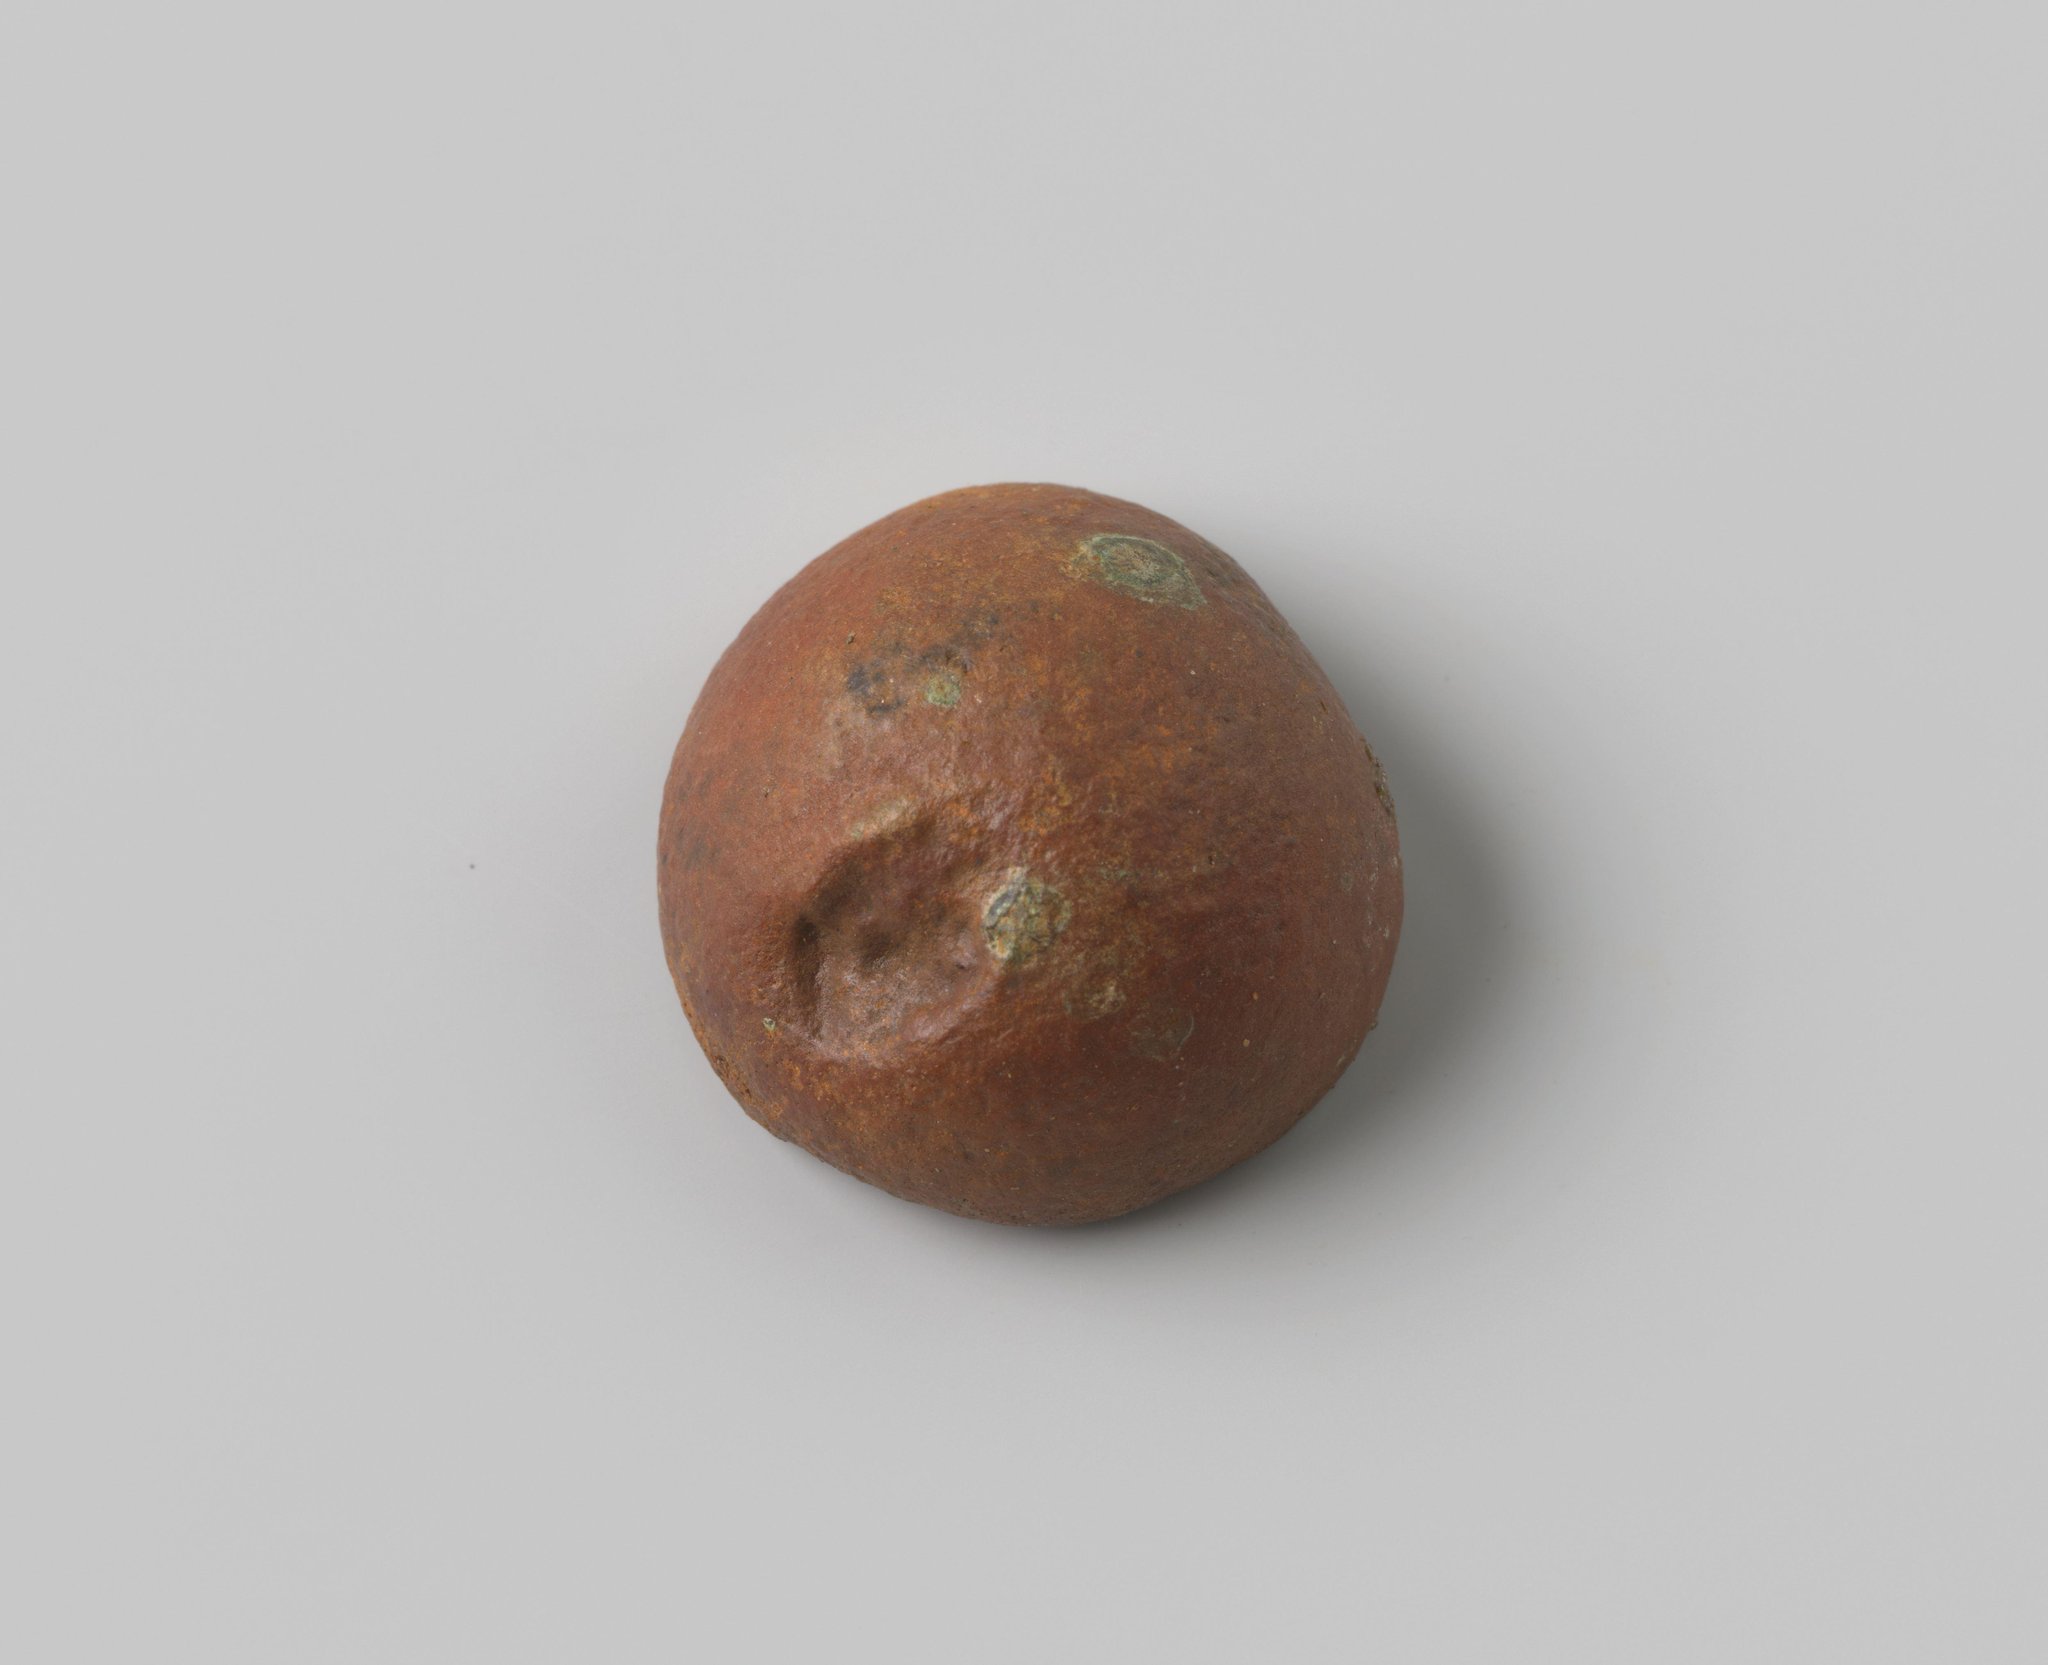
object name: bone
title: Fragment femurkop van schaap of geit uit het wrak van de Oost-Indiëvaarder Hollandia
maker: niet van toepassing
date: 1700-1743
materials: bone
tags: verenigde oostindische compagnie, hollandia (schip), annet